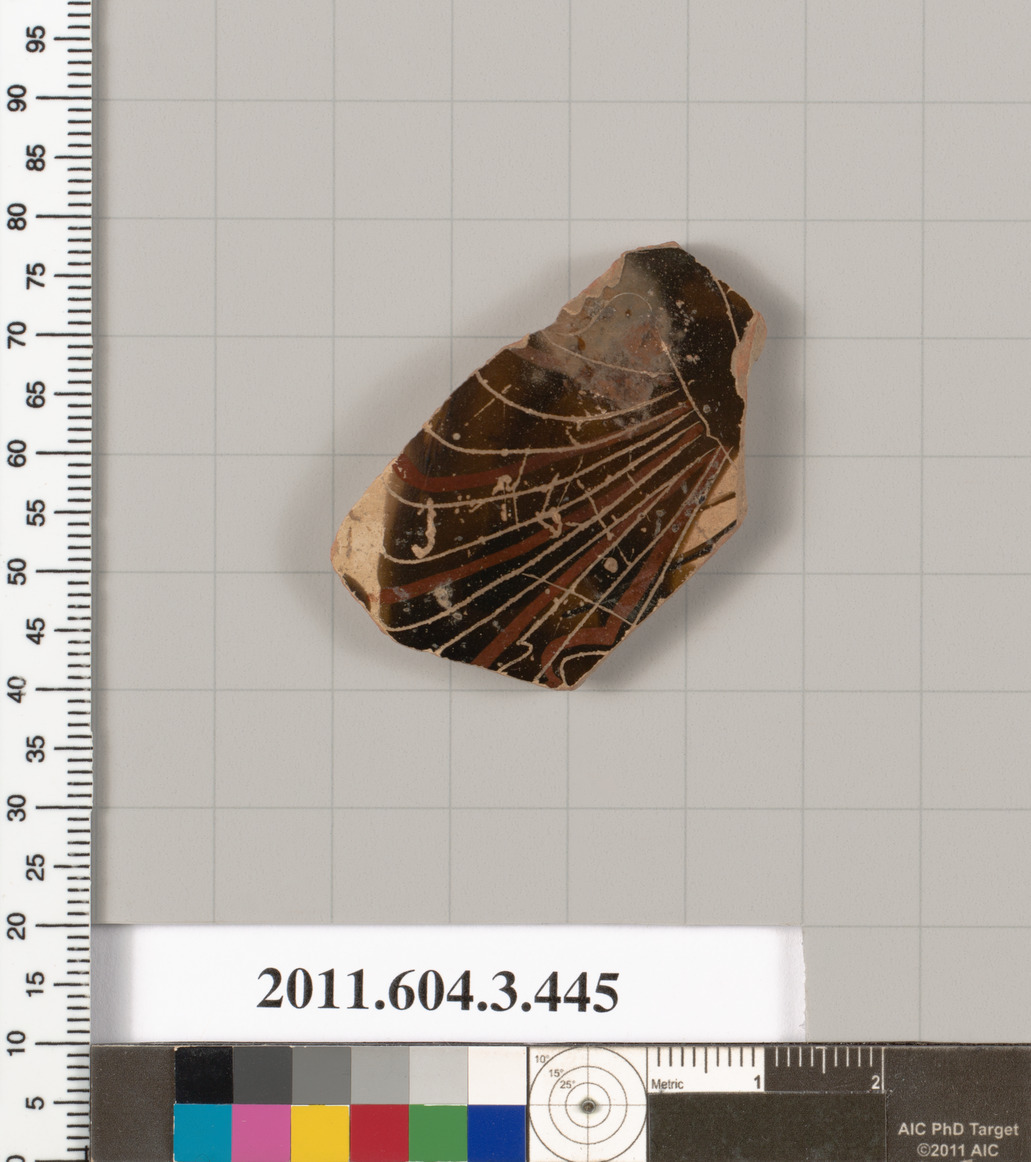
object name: neck amphora fragment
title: Terracotta fragment of a neck-amphora (jar)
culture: greek, attic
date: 490-480 BCE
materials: terracotta